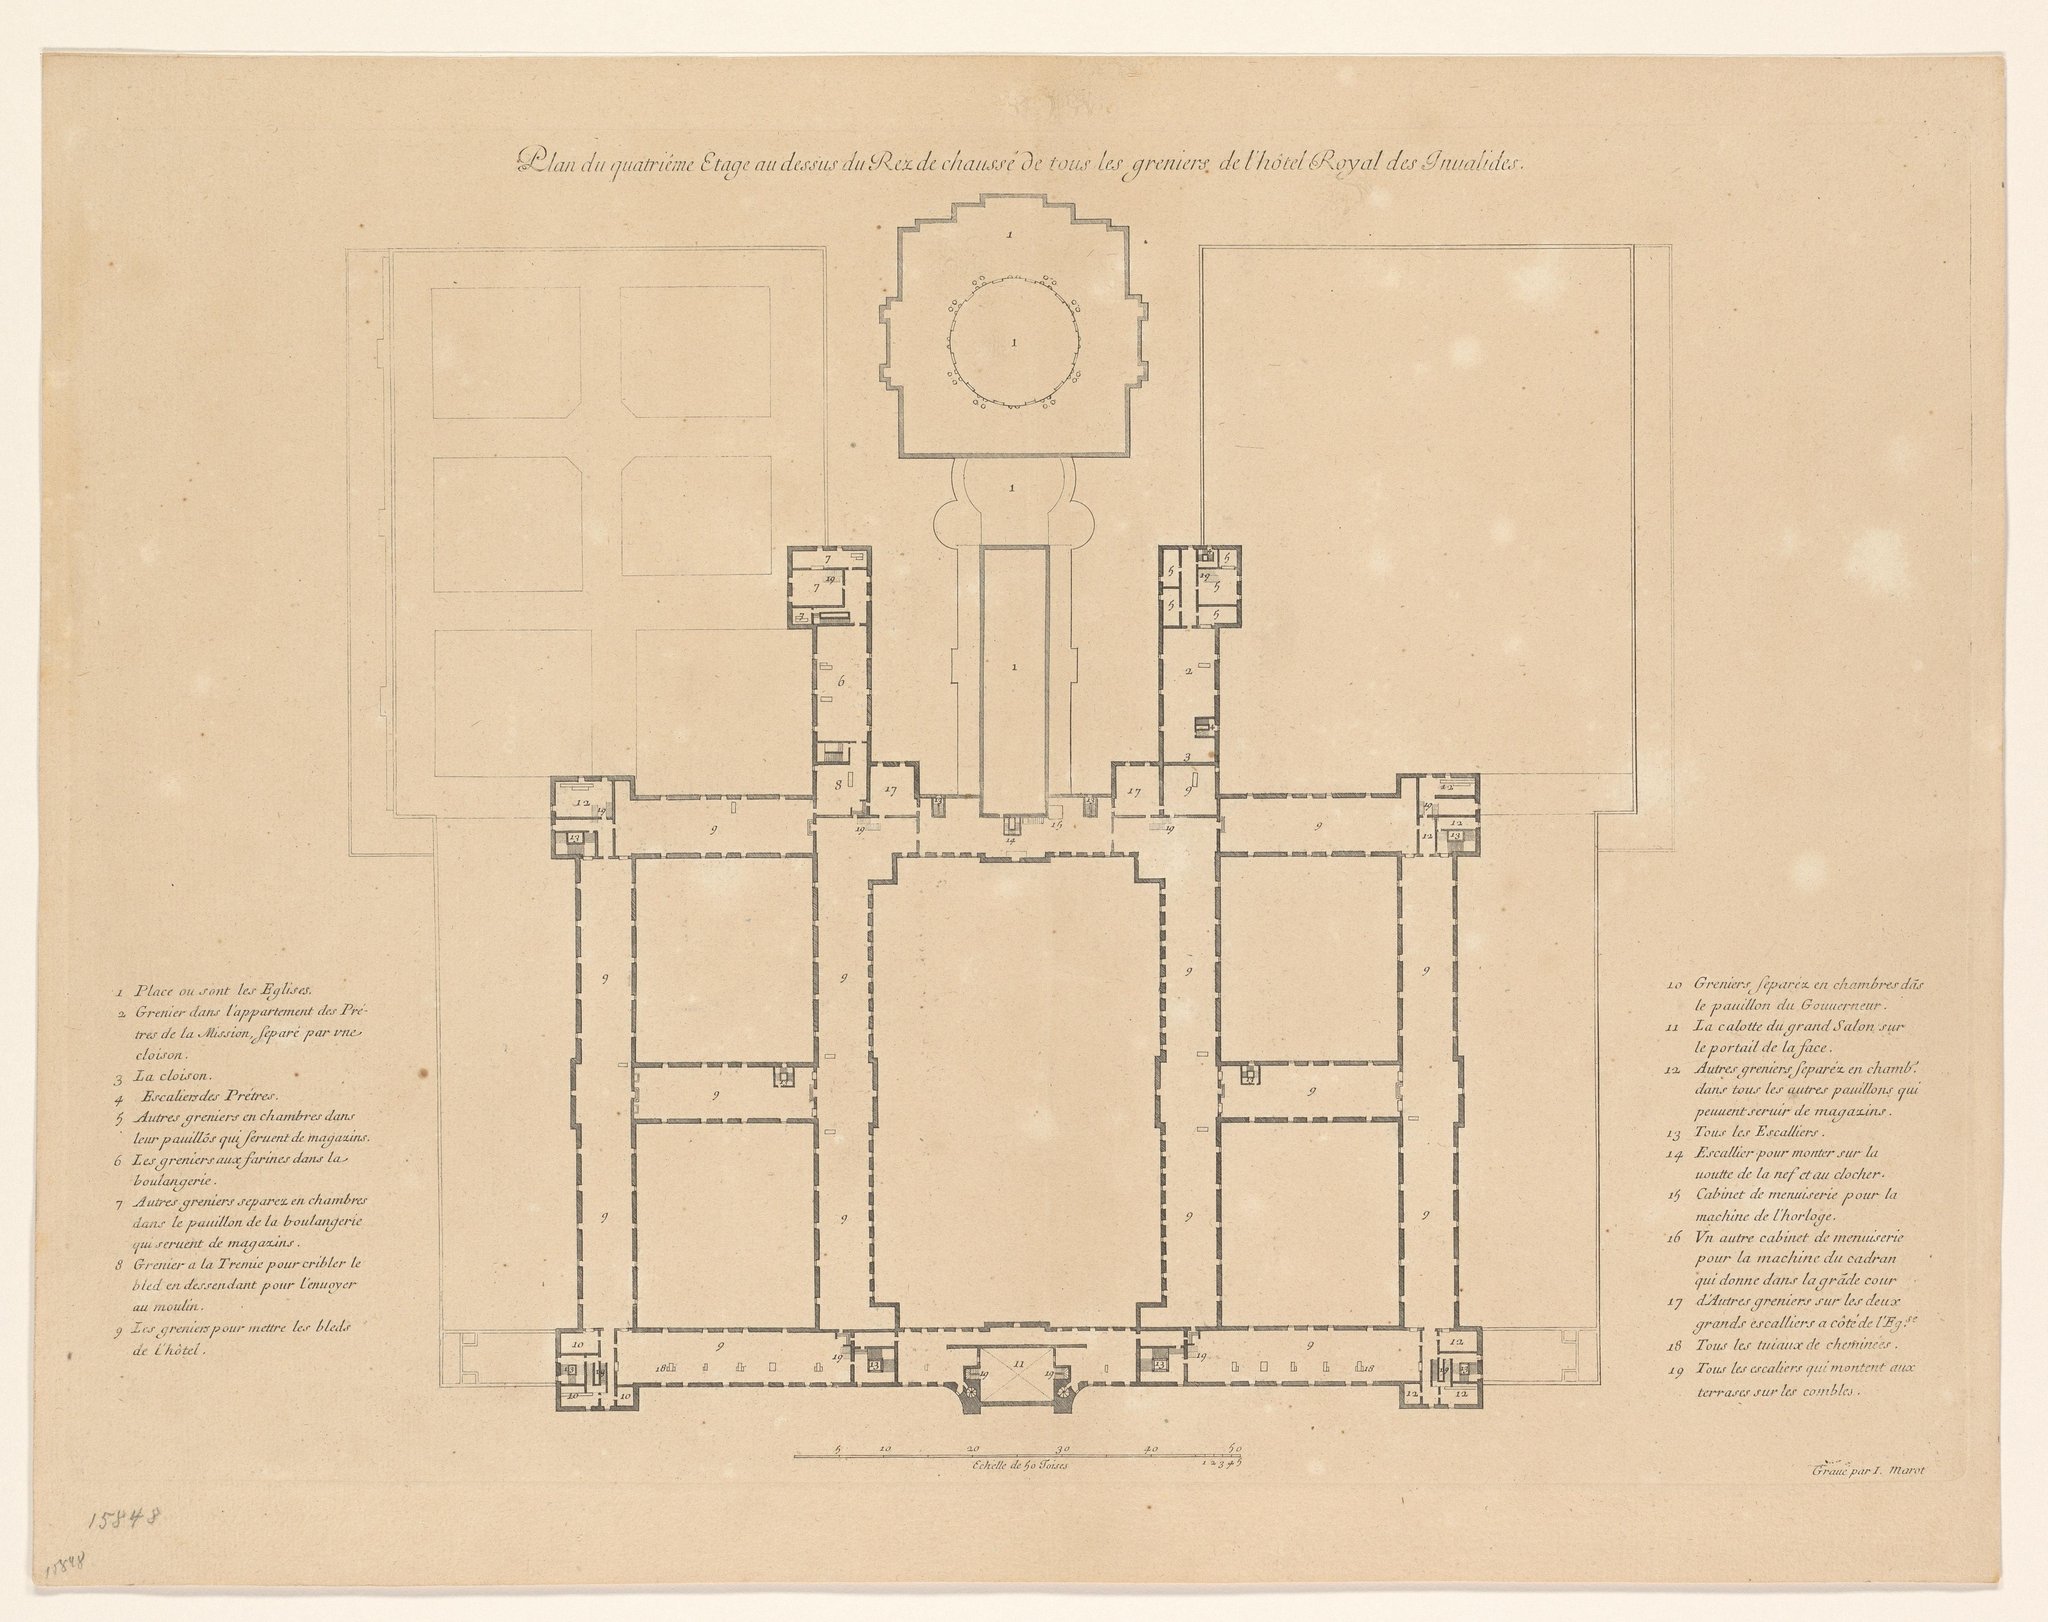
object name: area plan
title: Plan du quatriême Etgae au dessus du Rez de chaussé de tous les greniers de l'hôtel Royal des Invalides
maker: jean marot (i)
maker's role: print maker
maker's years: 1619-1679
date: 1670-1679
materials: paper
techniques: etching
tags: plan ~ architecture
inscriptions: collector's mark: Lugt 2228, number: ‘15848’